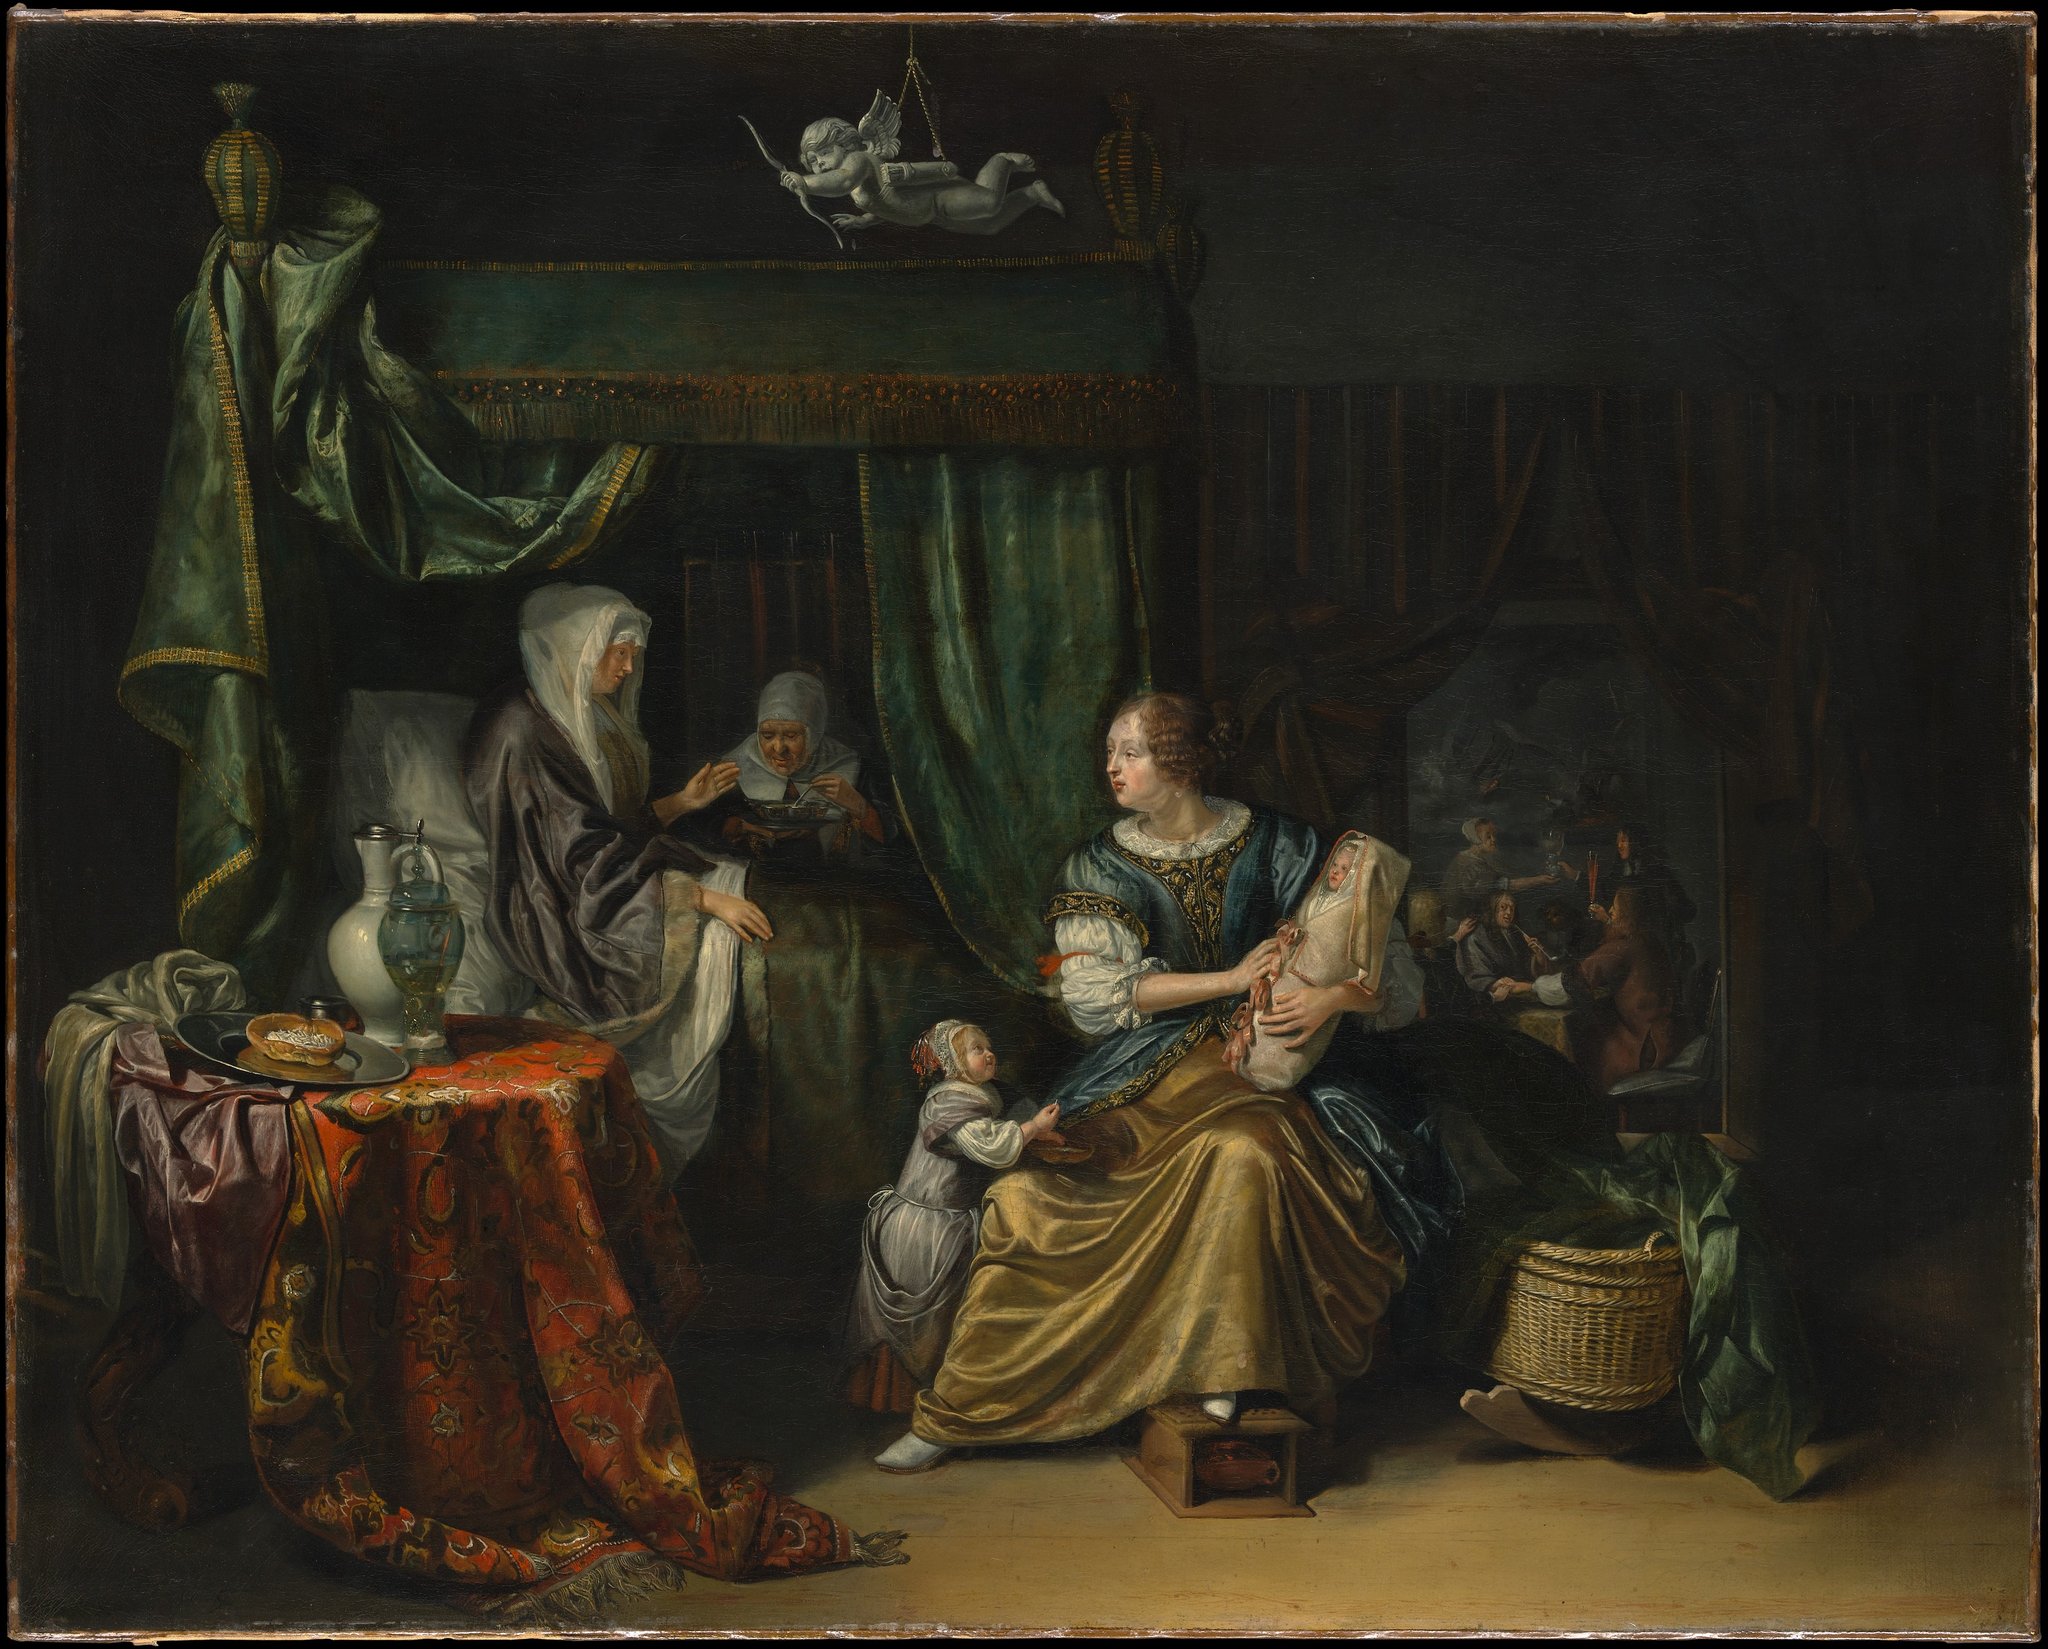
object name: painting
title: The Newborn Baby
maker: matthijs naiveu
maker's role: artist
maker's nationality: dutch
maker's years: 1647-1726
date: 1675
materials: canvas, oil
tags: bedrooms,children,infants,women